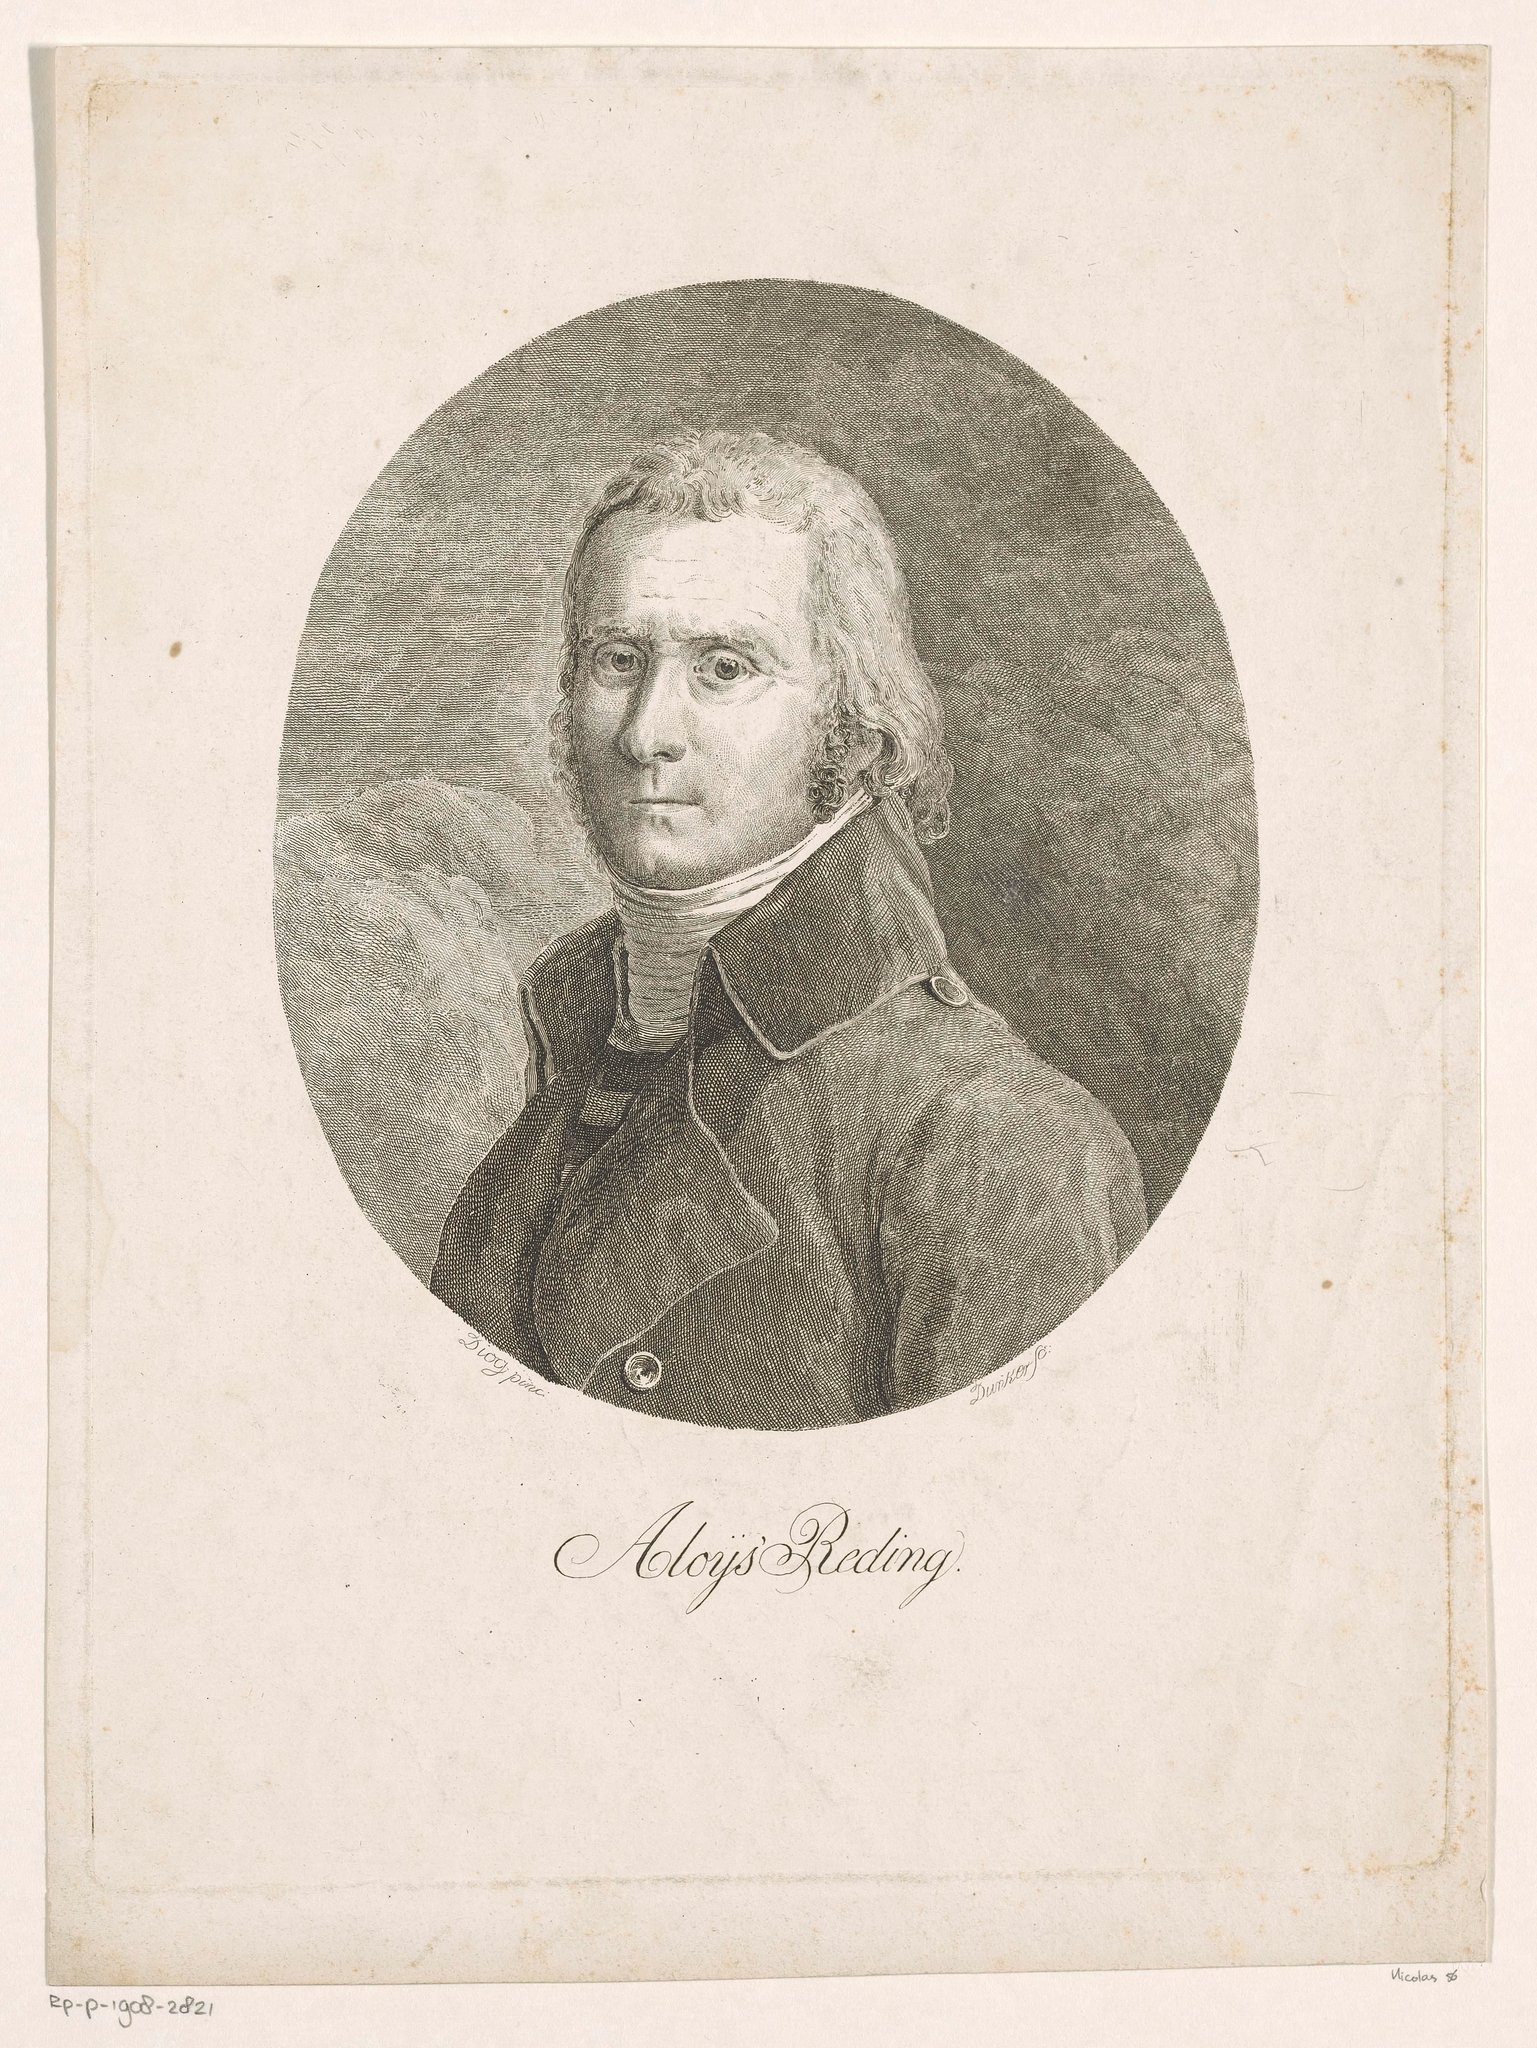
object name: print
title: Portret van Alois Reding von Biberegg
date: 1775-1807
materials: paper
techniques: etching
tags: politician, historical persons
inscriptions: collector's mark: Lugt 2228